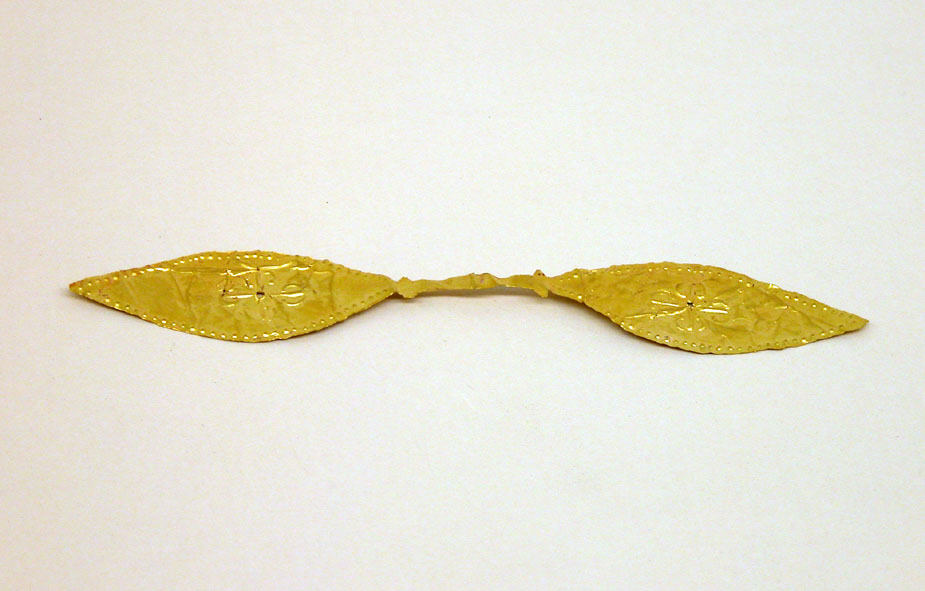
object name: mask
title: Ritual Eye Mask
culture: indonesian, javanese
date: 201-300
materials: gold